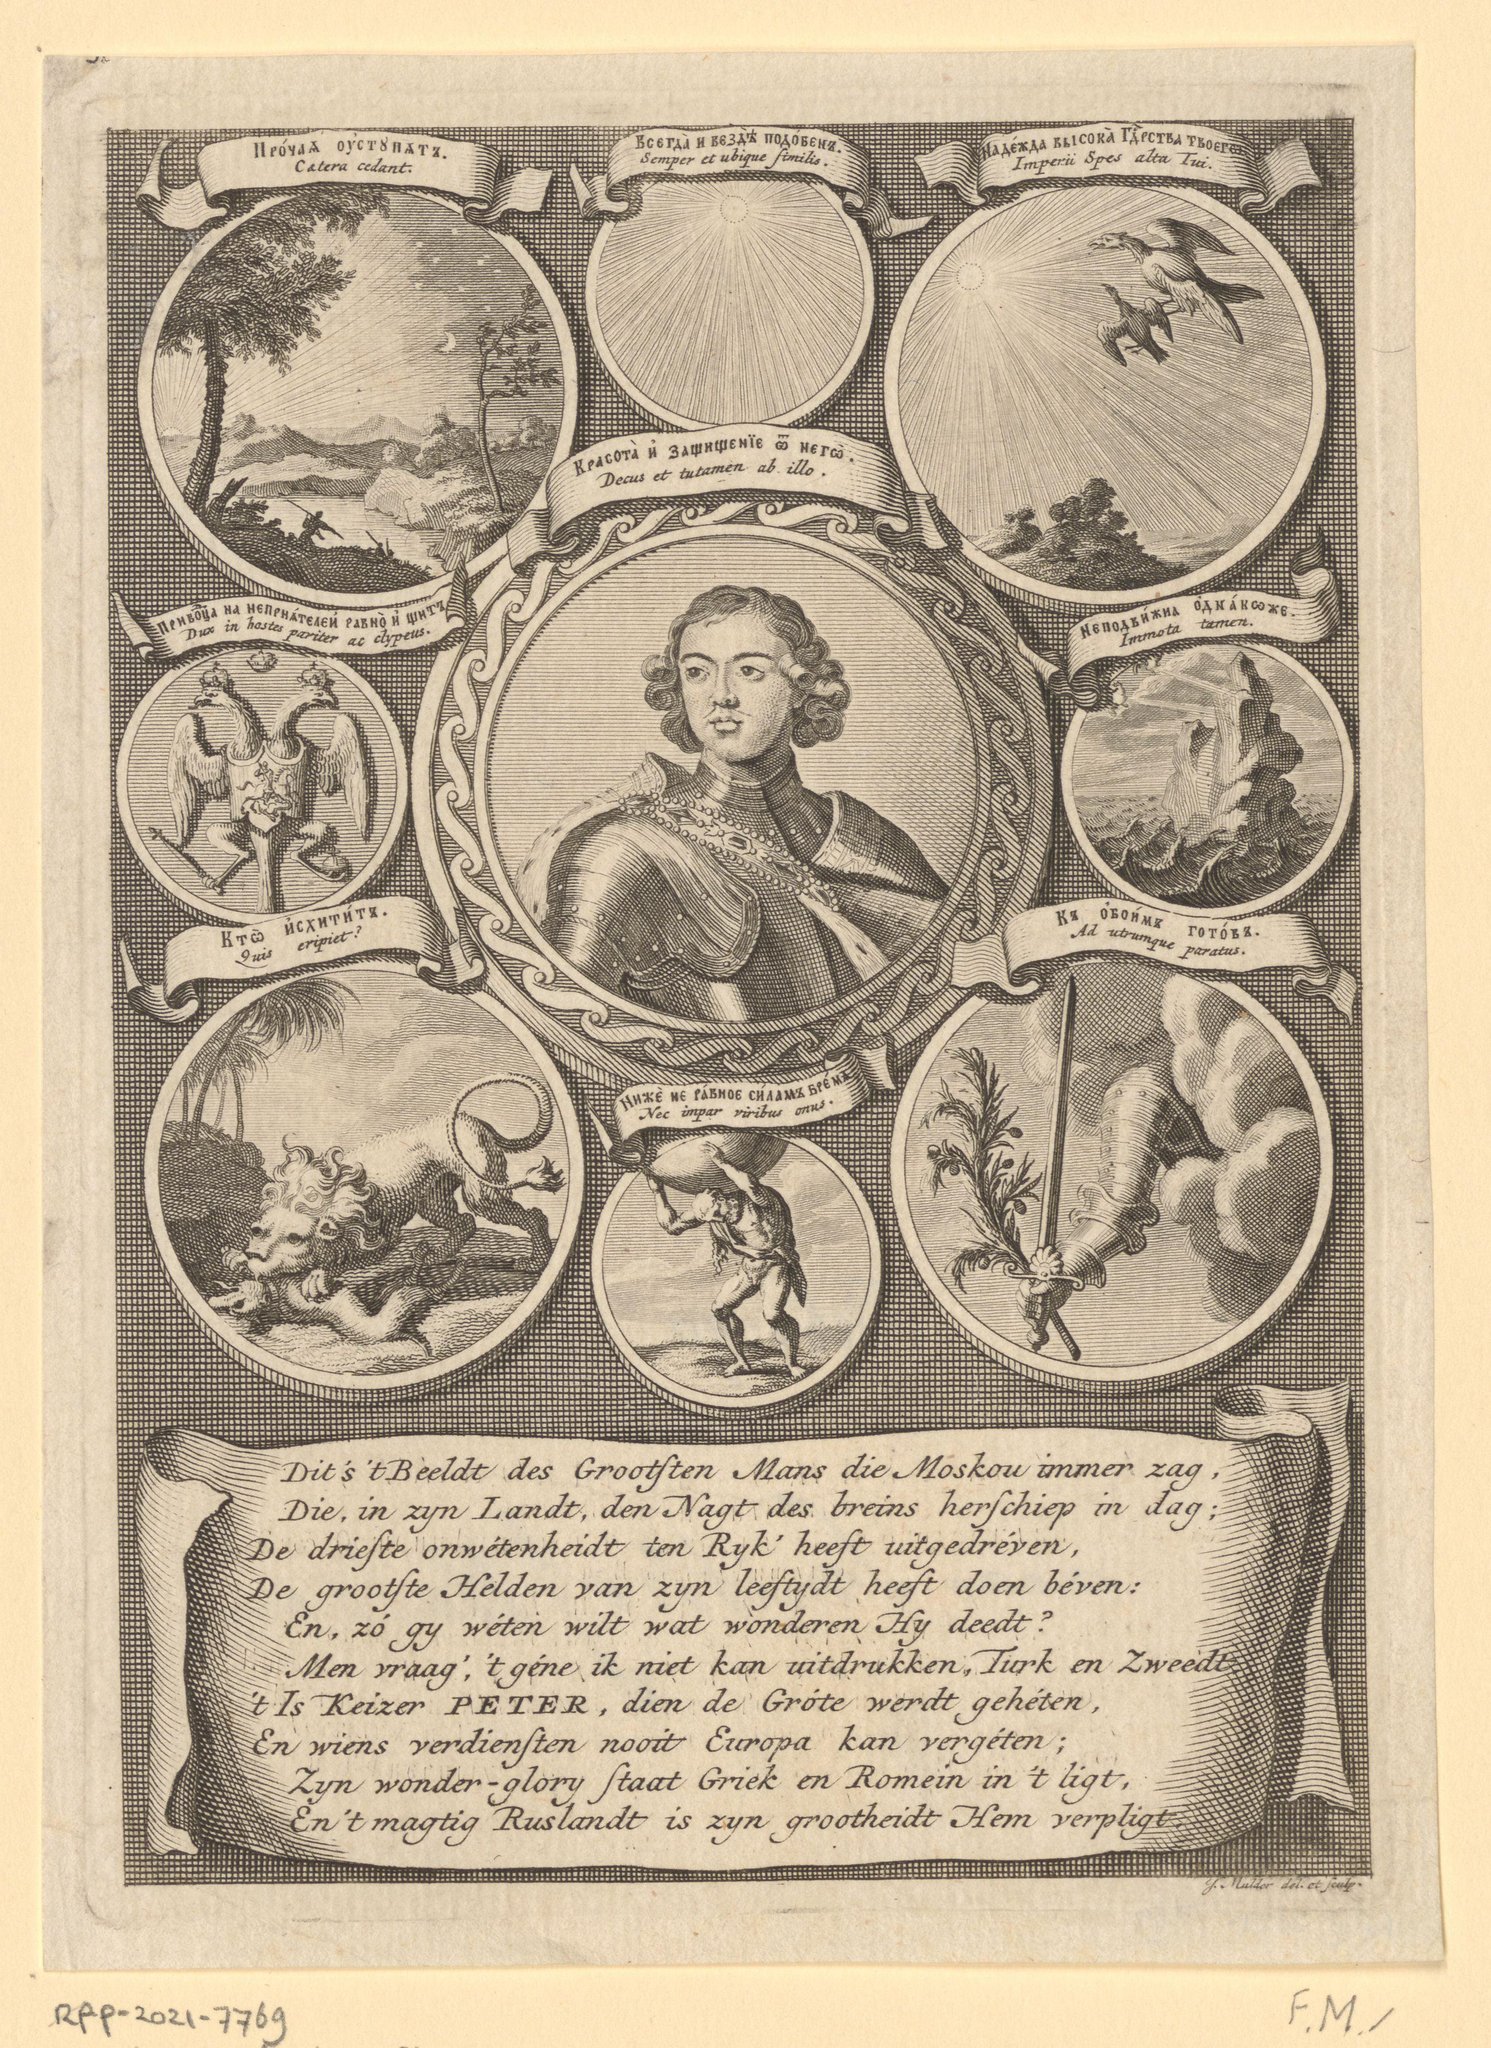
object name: print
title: Portret van Peter I de Grote, tsaar van Rusland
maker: j. mulder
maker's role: print maker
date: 1743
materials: paper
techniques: engraving, etching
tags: peter i de grote (tsaar van rusland), adult man, historical persons, hacking and thrusting weapons: sword, beasts of prey, predatory animals: lion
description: Portret van Peter I de Grote omringd door acht voorstellingen bestaande uit de zon, arenden, een rots, een leeuw met prooi, een man met gewicht op zijn rug en een arm met zwaard en olijftak.